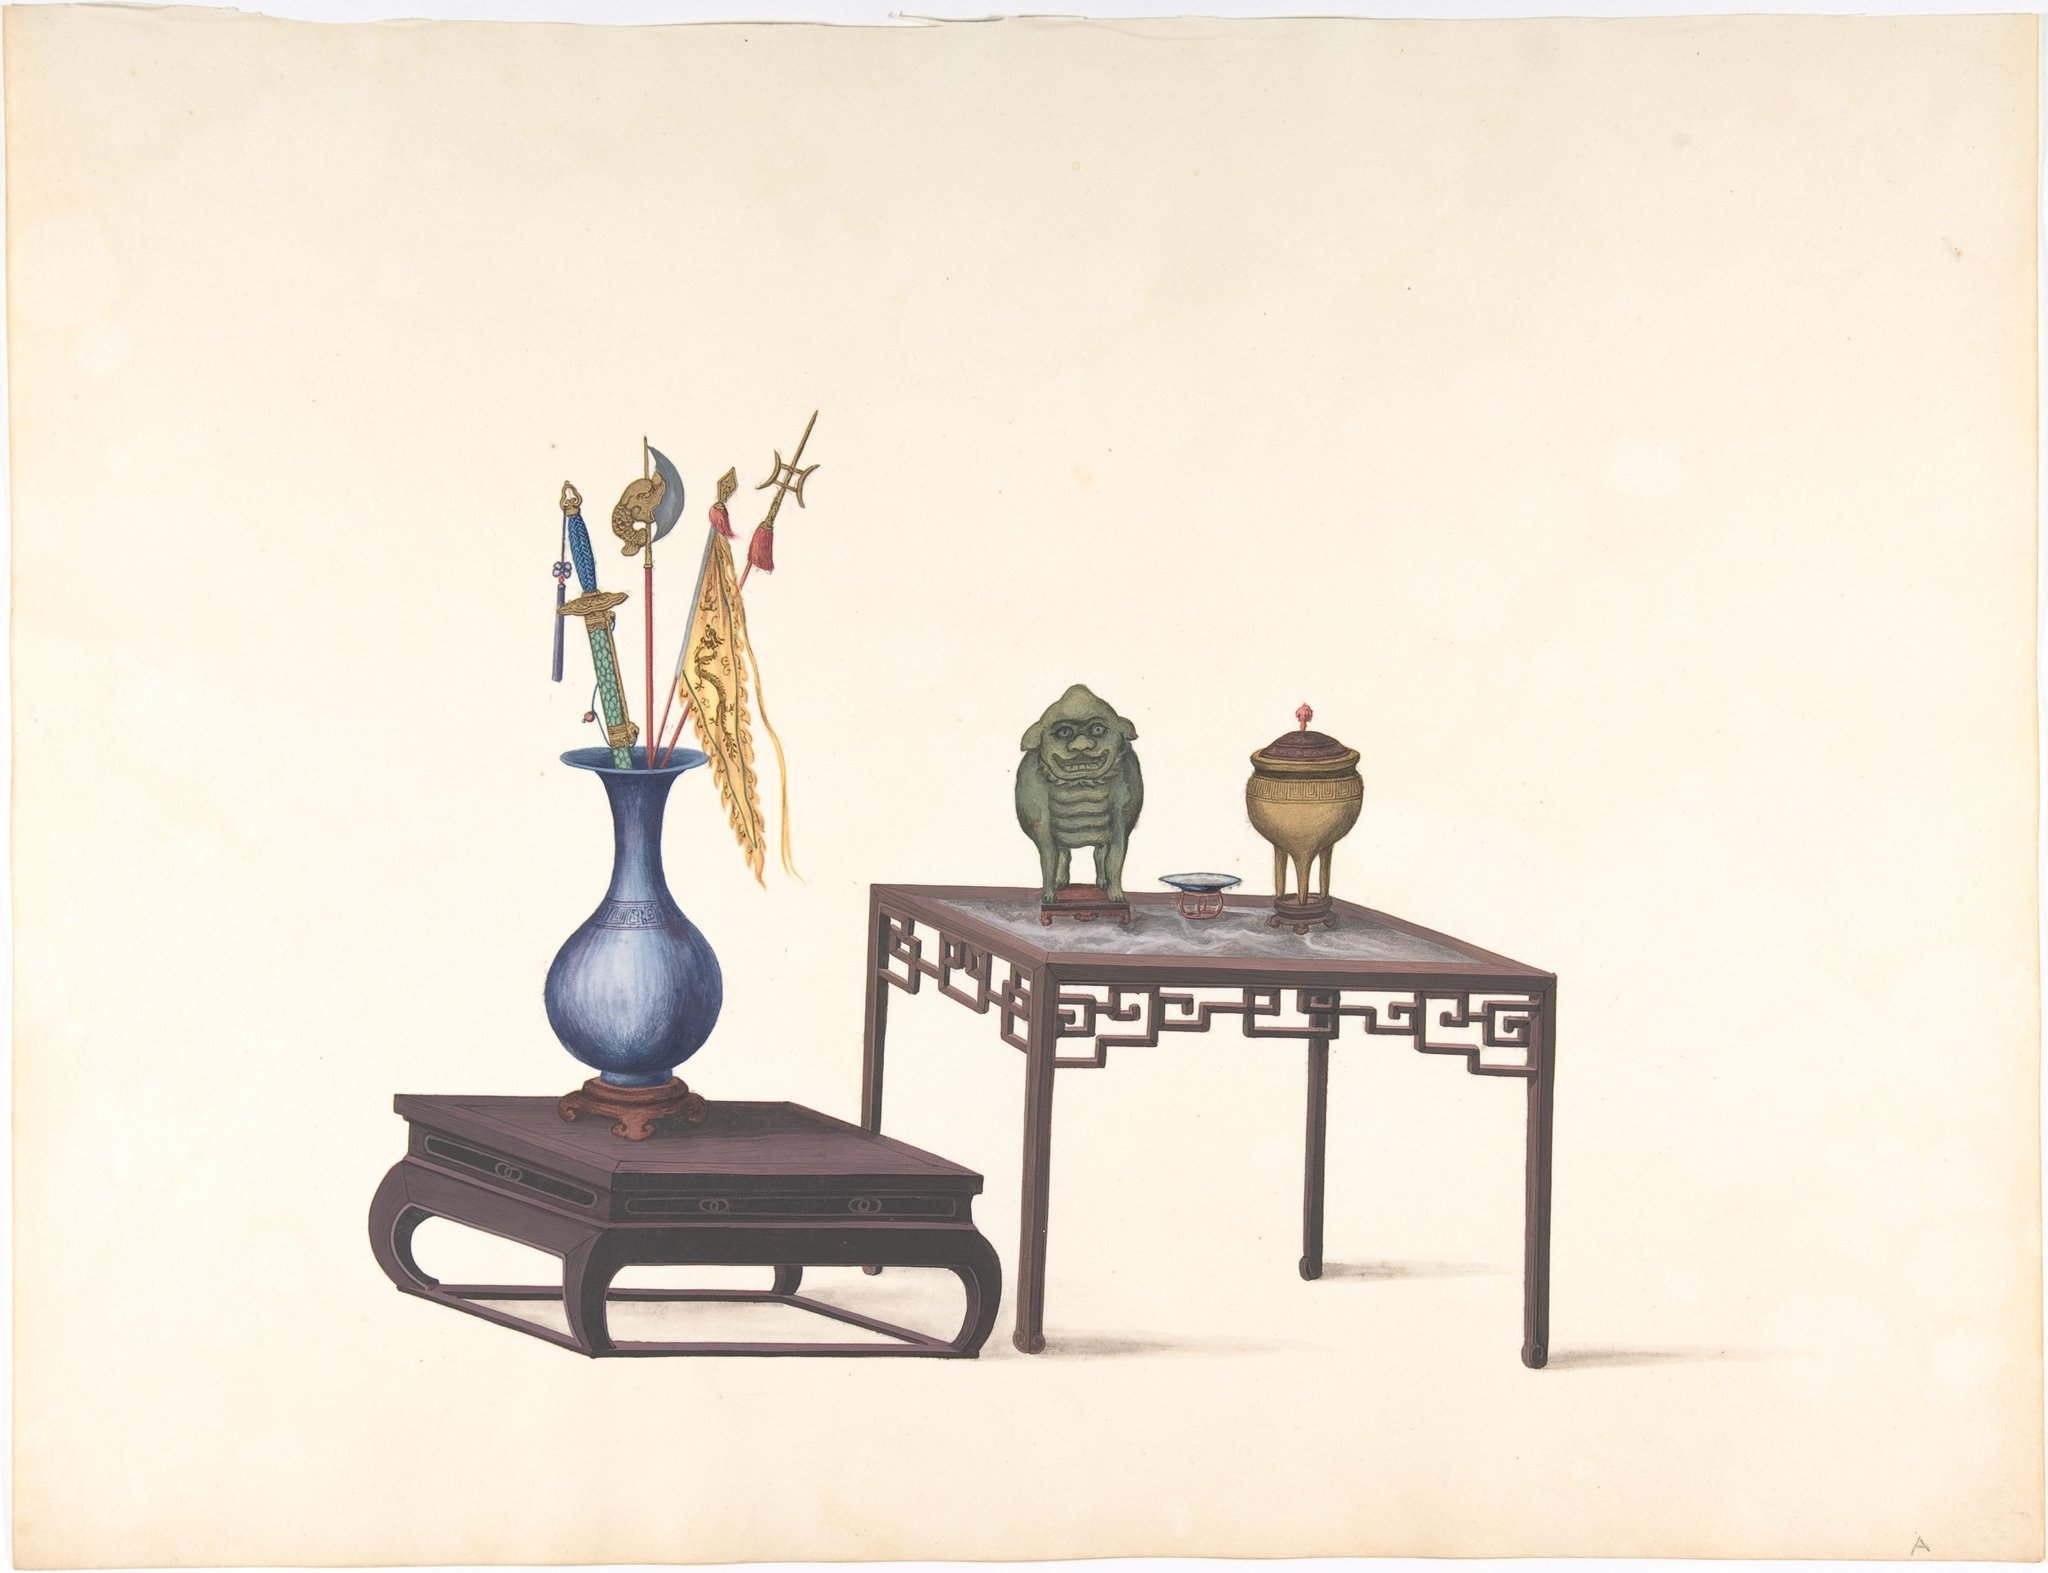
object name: drawing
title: Two Tables, One Low with Large Vase and Objects, One Higher with Covered Pot, Lion and Small Bowl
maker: anonymous, chinese, 19th century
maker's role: artist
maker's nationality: chinese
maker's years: 1800-1900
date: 1801-1900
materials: gouache, ink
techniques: pen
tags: bowls,tables,vases